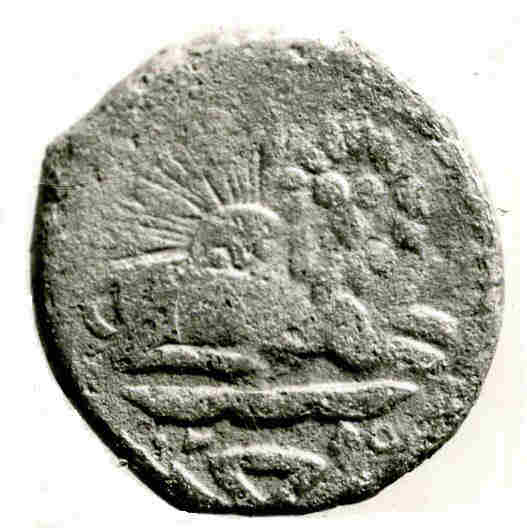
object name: coin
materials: copper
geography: iran